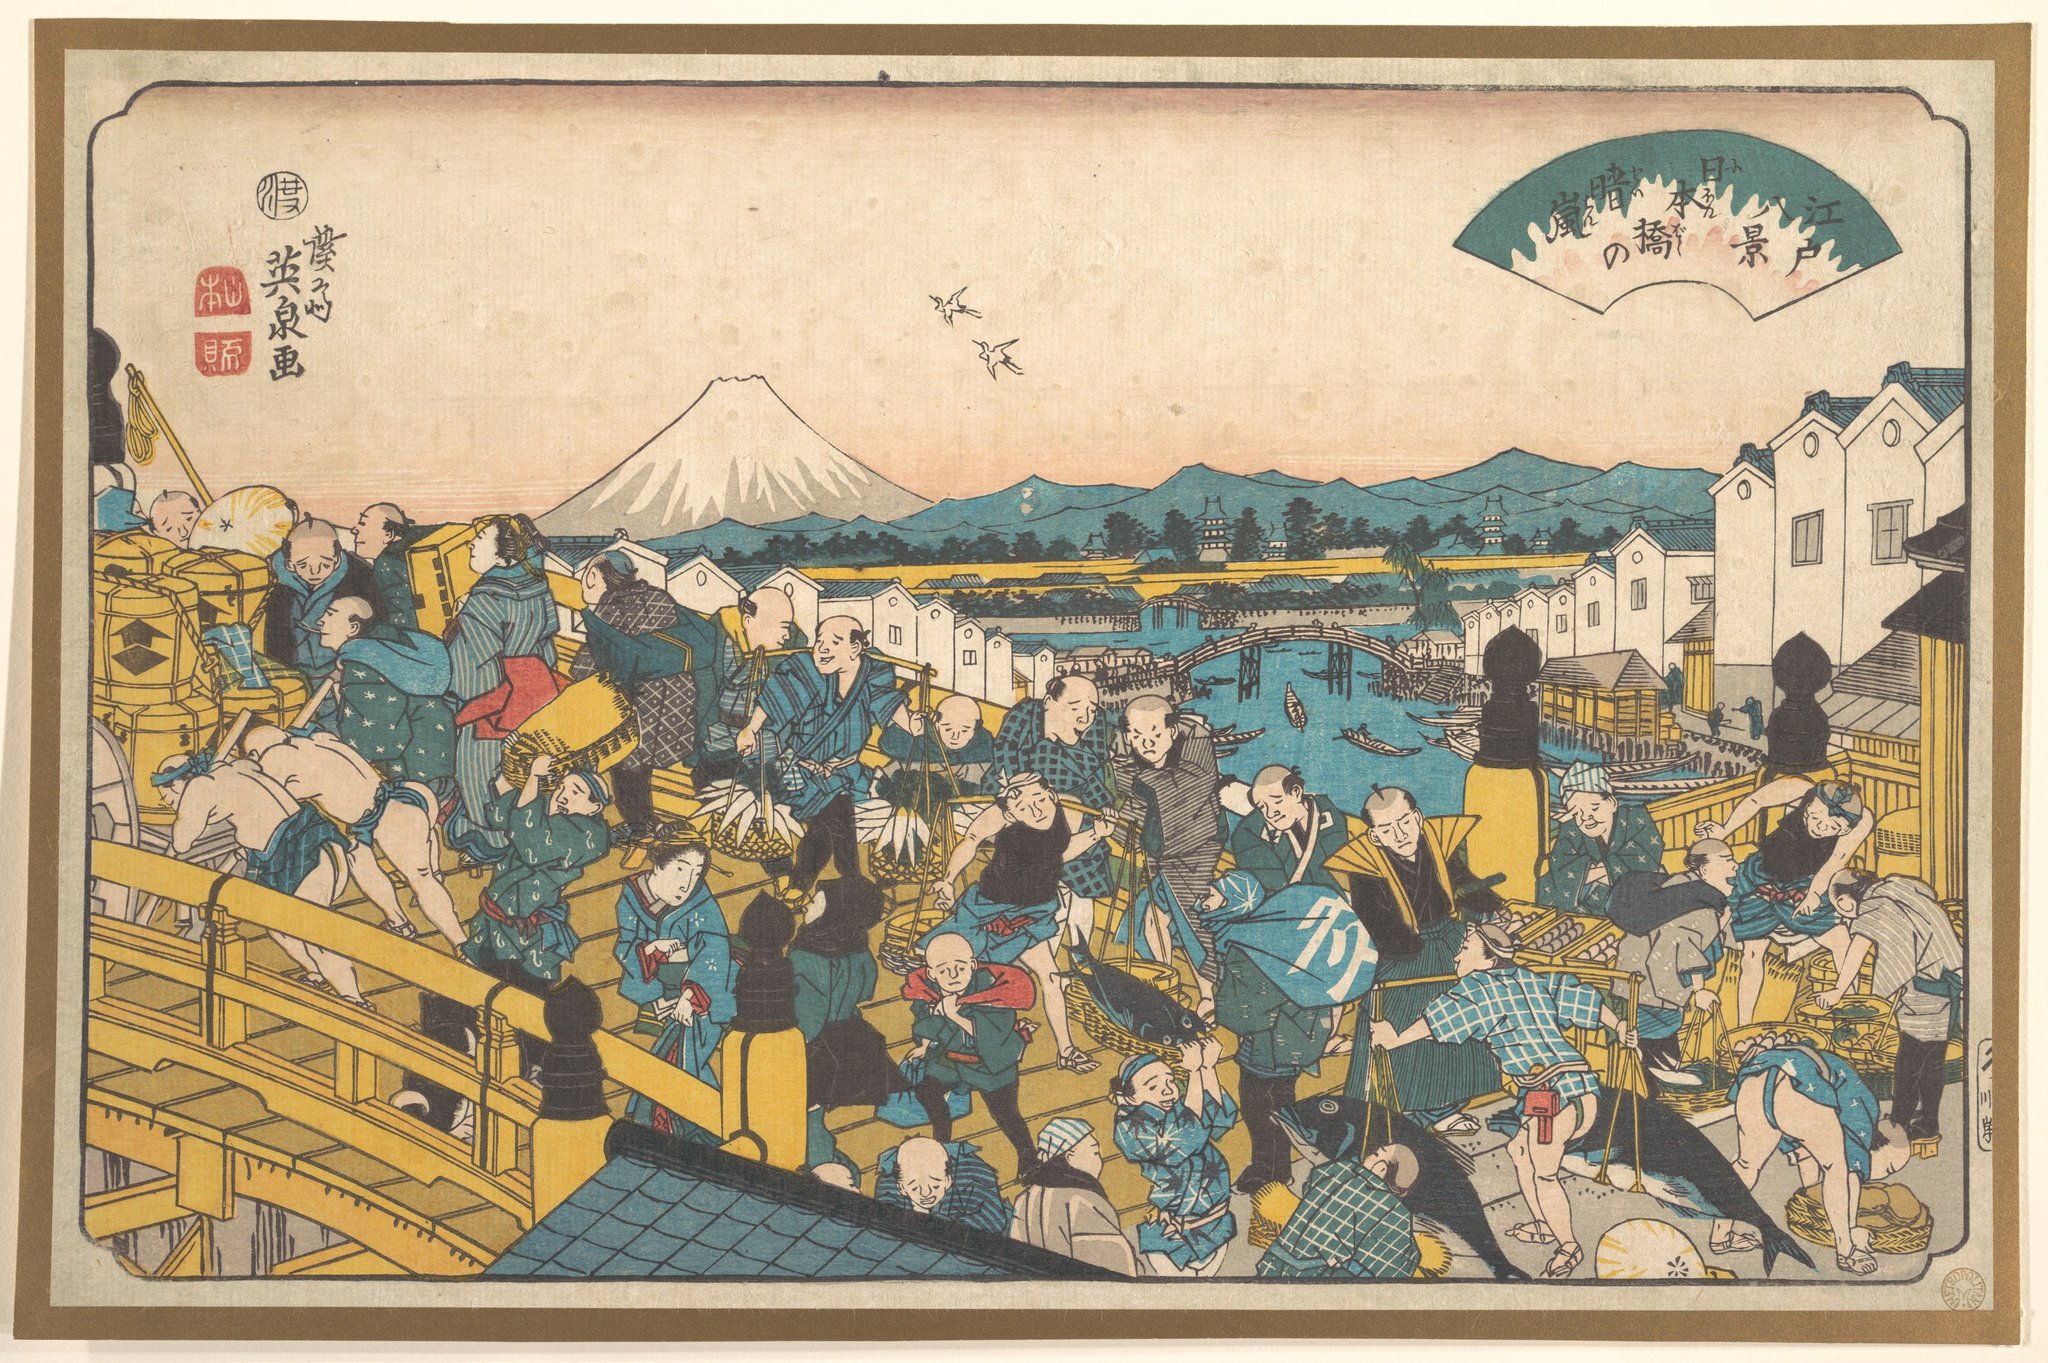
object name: print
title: Evening Glow at Nihonbashi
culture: japanese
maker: keisai eisen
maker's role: artist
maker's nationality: japanese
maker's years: 1790-1848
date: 1834-1866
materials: ink, paper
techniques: woodblock print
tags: bridges,fish,crowd